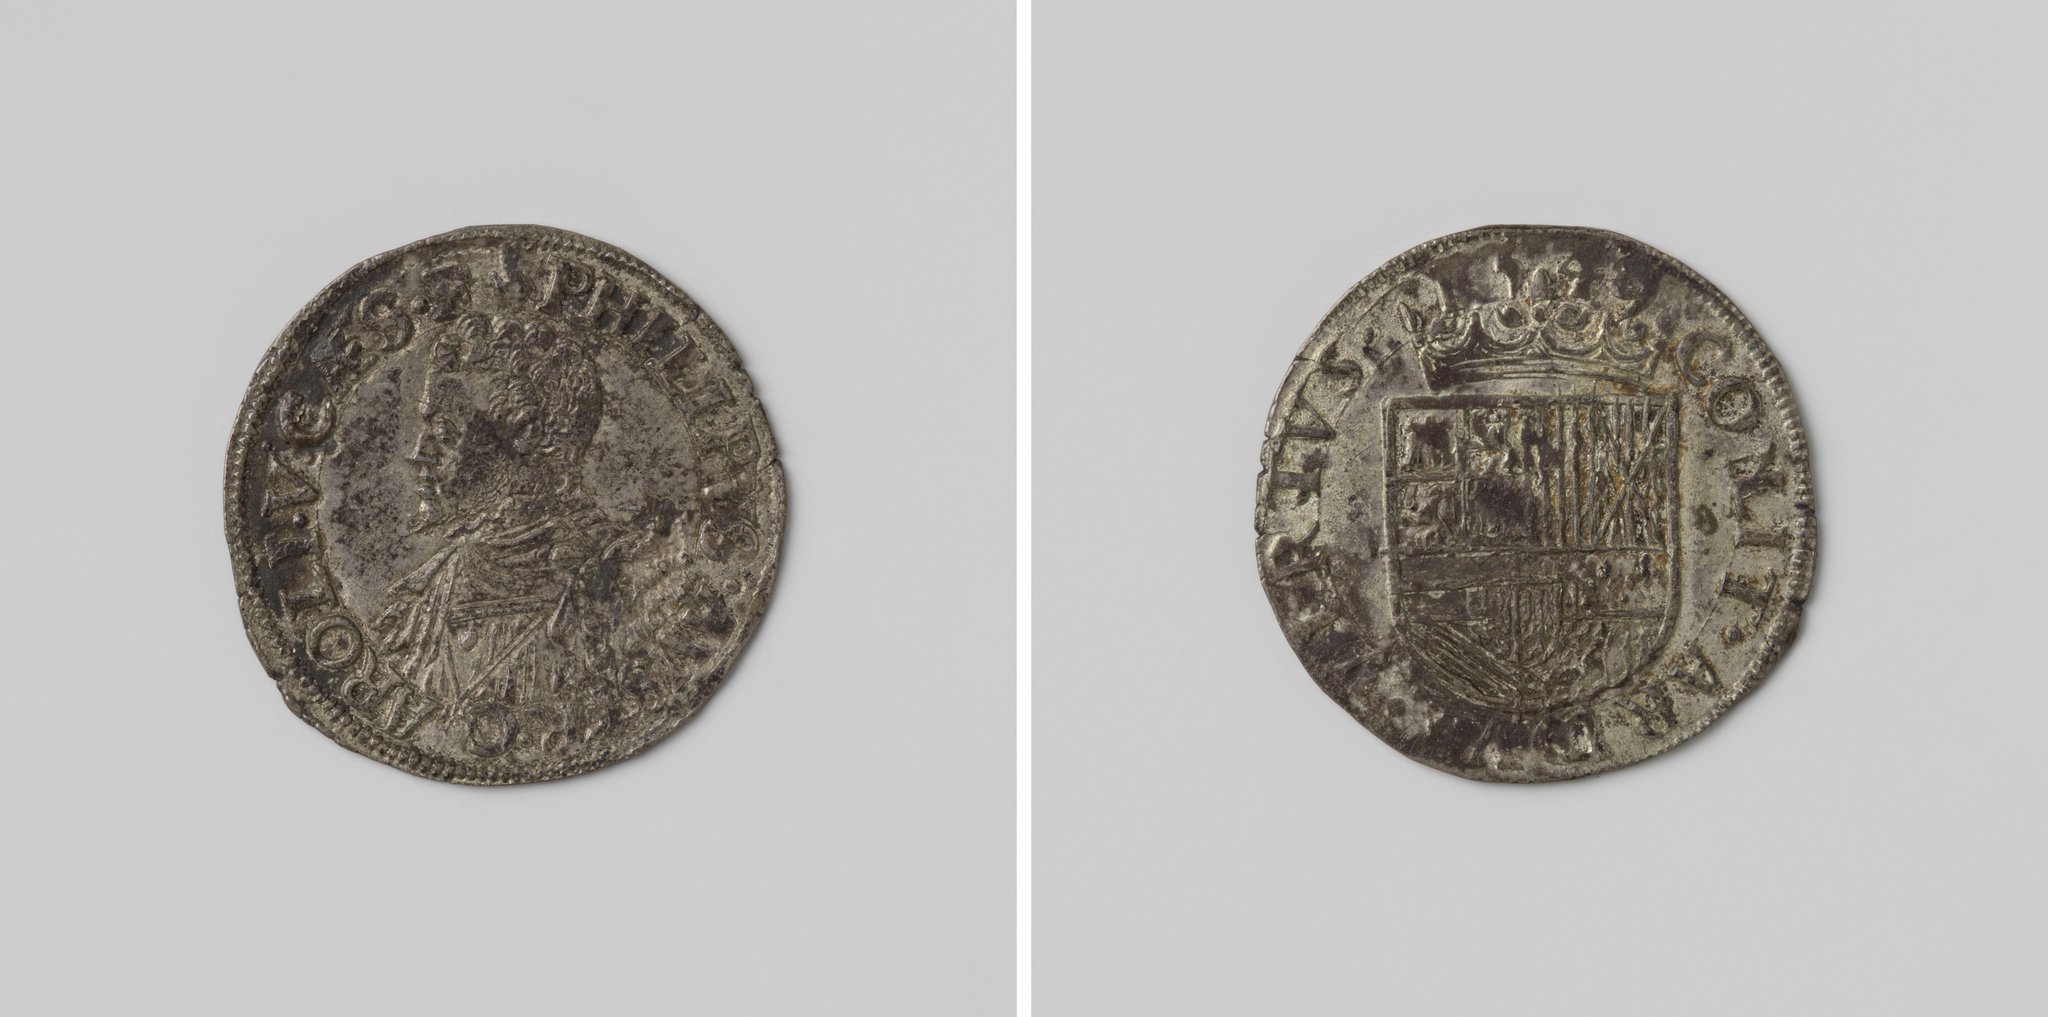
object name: jeton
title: Filips, erfprins van Spanje, ingehuldigd als graaf van Holland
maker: Anonymous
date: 1549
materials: silver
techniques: striking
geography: antwerp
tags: philip ii of spain, county of holland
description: Zilveren penning. Voorzijde: borststuk man binnen omschrift. Keerzijde: gekroond wapenschild, omhangen met de orde van Gulden Vlies binnen omschrift